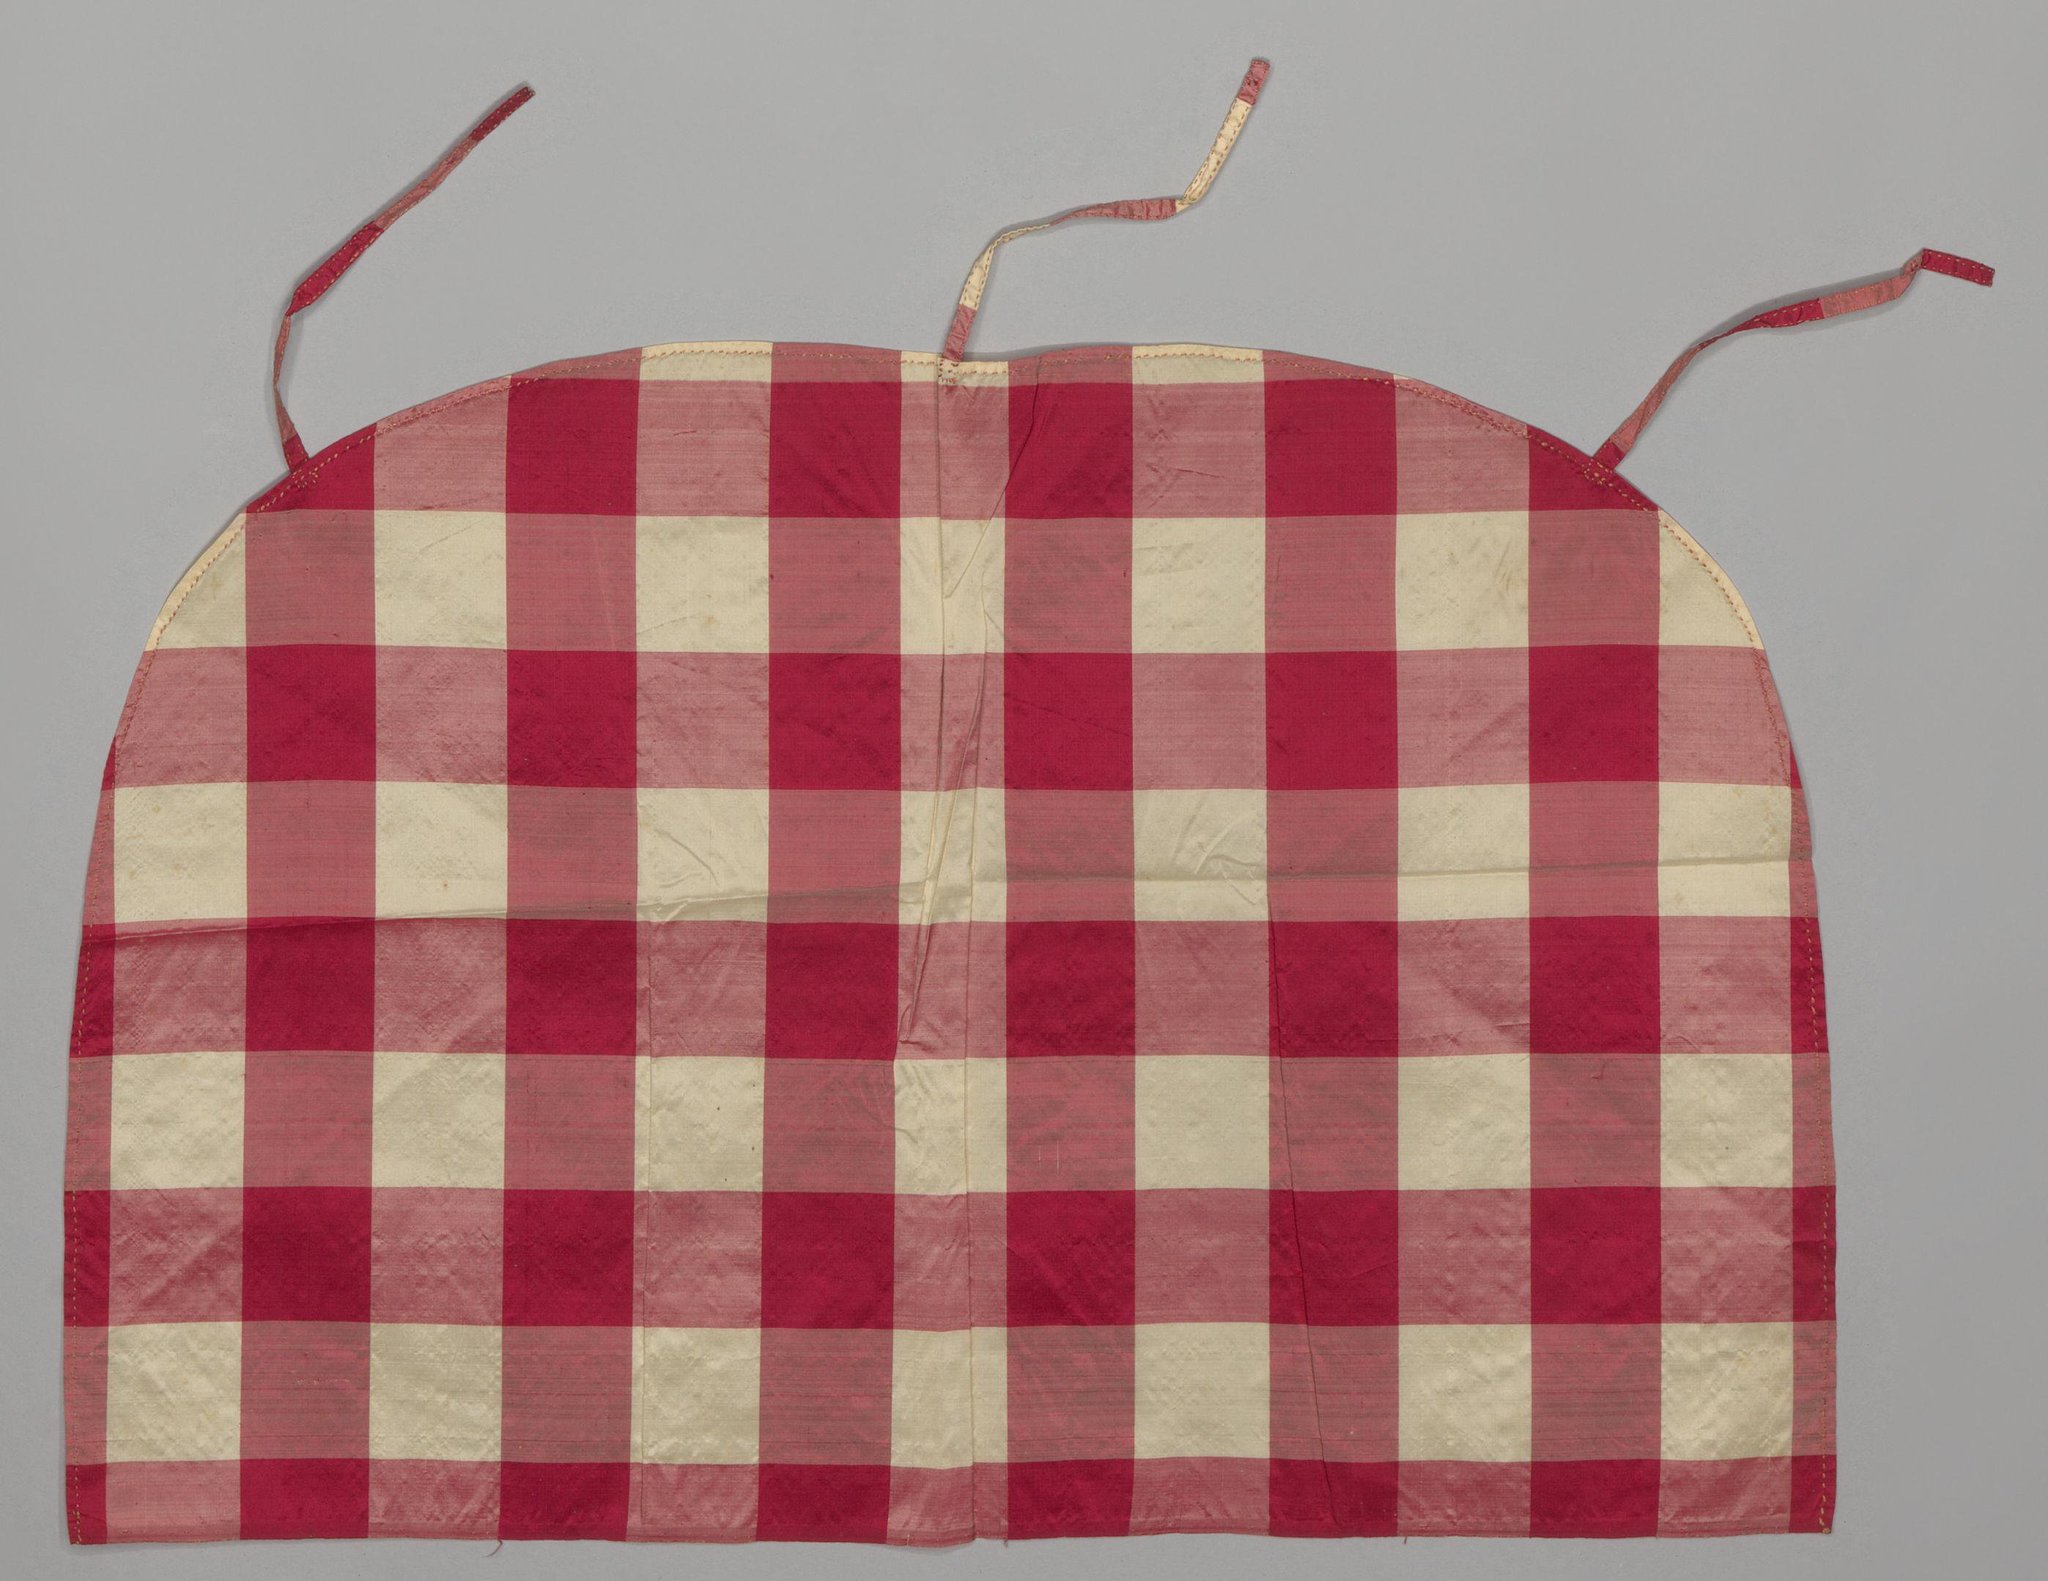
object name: gordijnval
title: Gordijngarnituur, mogelijk een gordijnval, van rood-wit geblokte zijde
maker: Anonymous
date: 1776-1800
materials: silk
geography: northern netherlands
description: Schildvormig gordijngarnituur, mogelijk een gordijnval, met drie bandjes van dezelfde stof van ca. 10.0 cm.